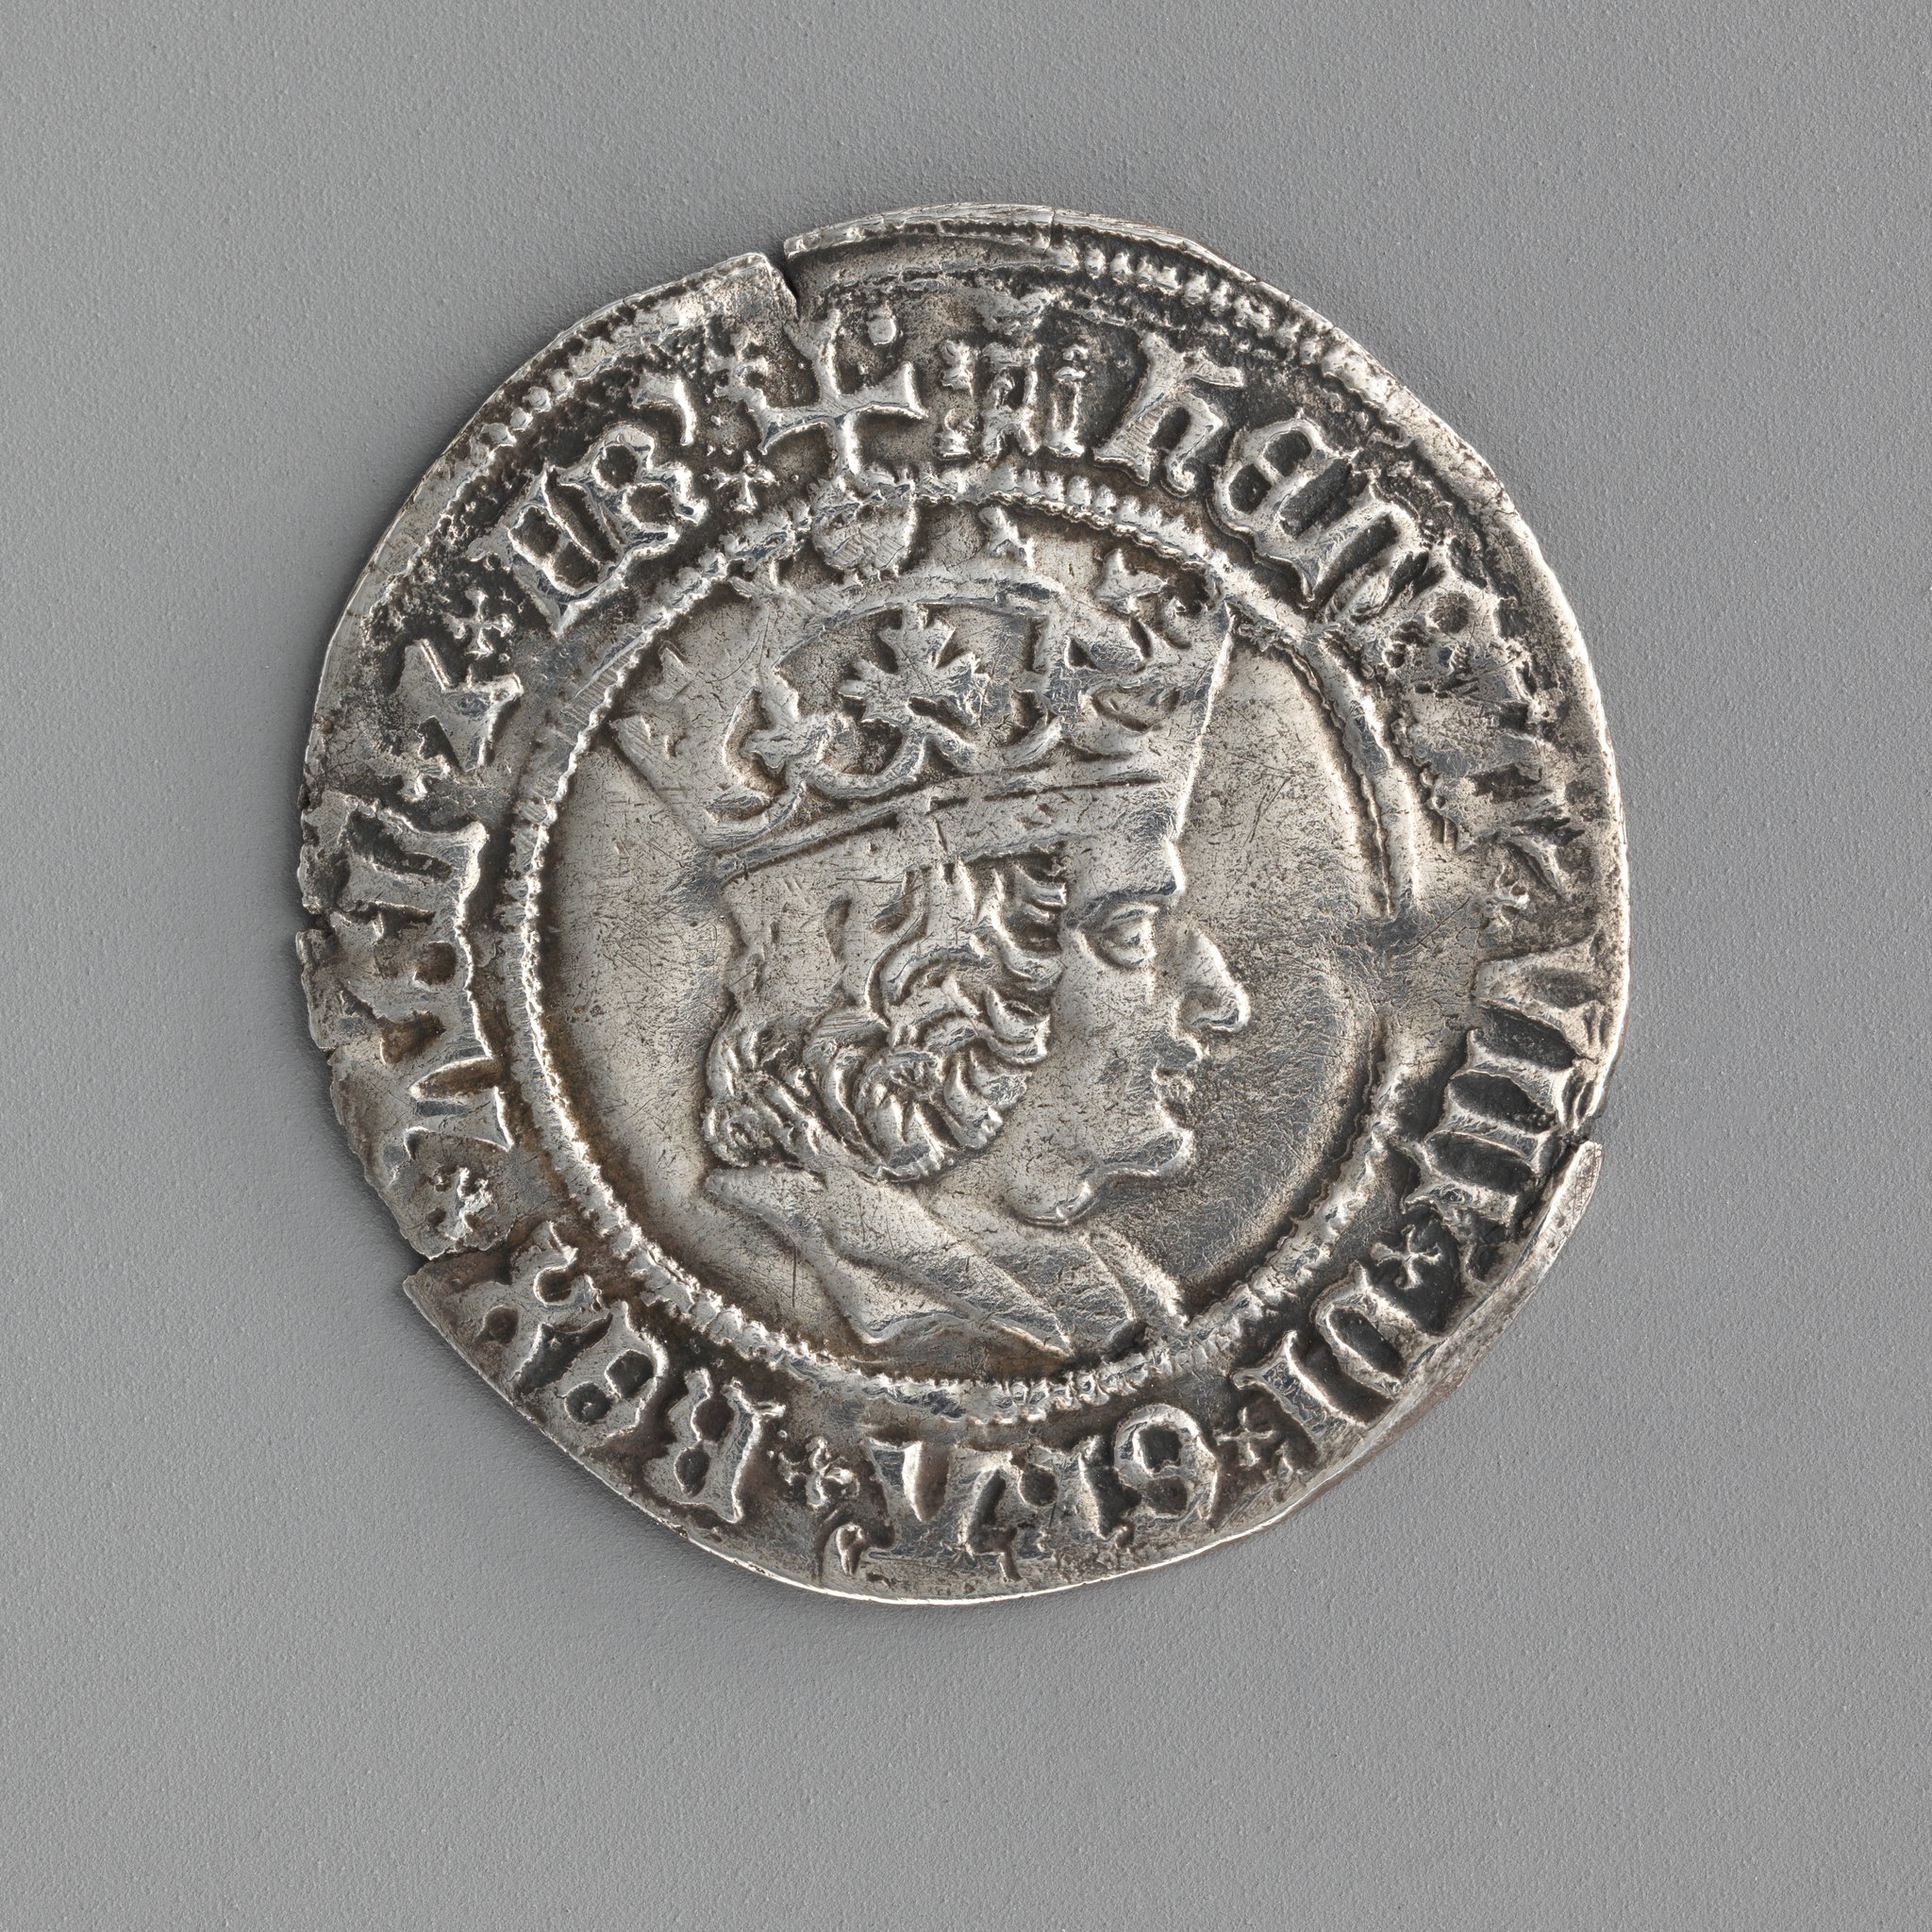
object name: groat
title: Groat of Henry VIII (first coinage)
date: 1509-1526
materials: silver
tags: henry viii,profiles,coins